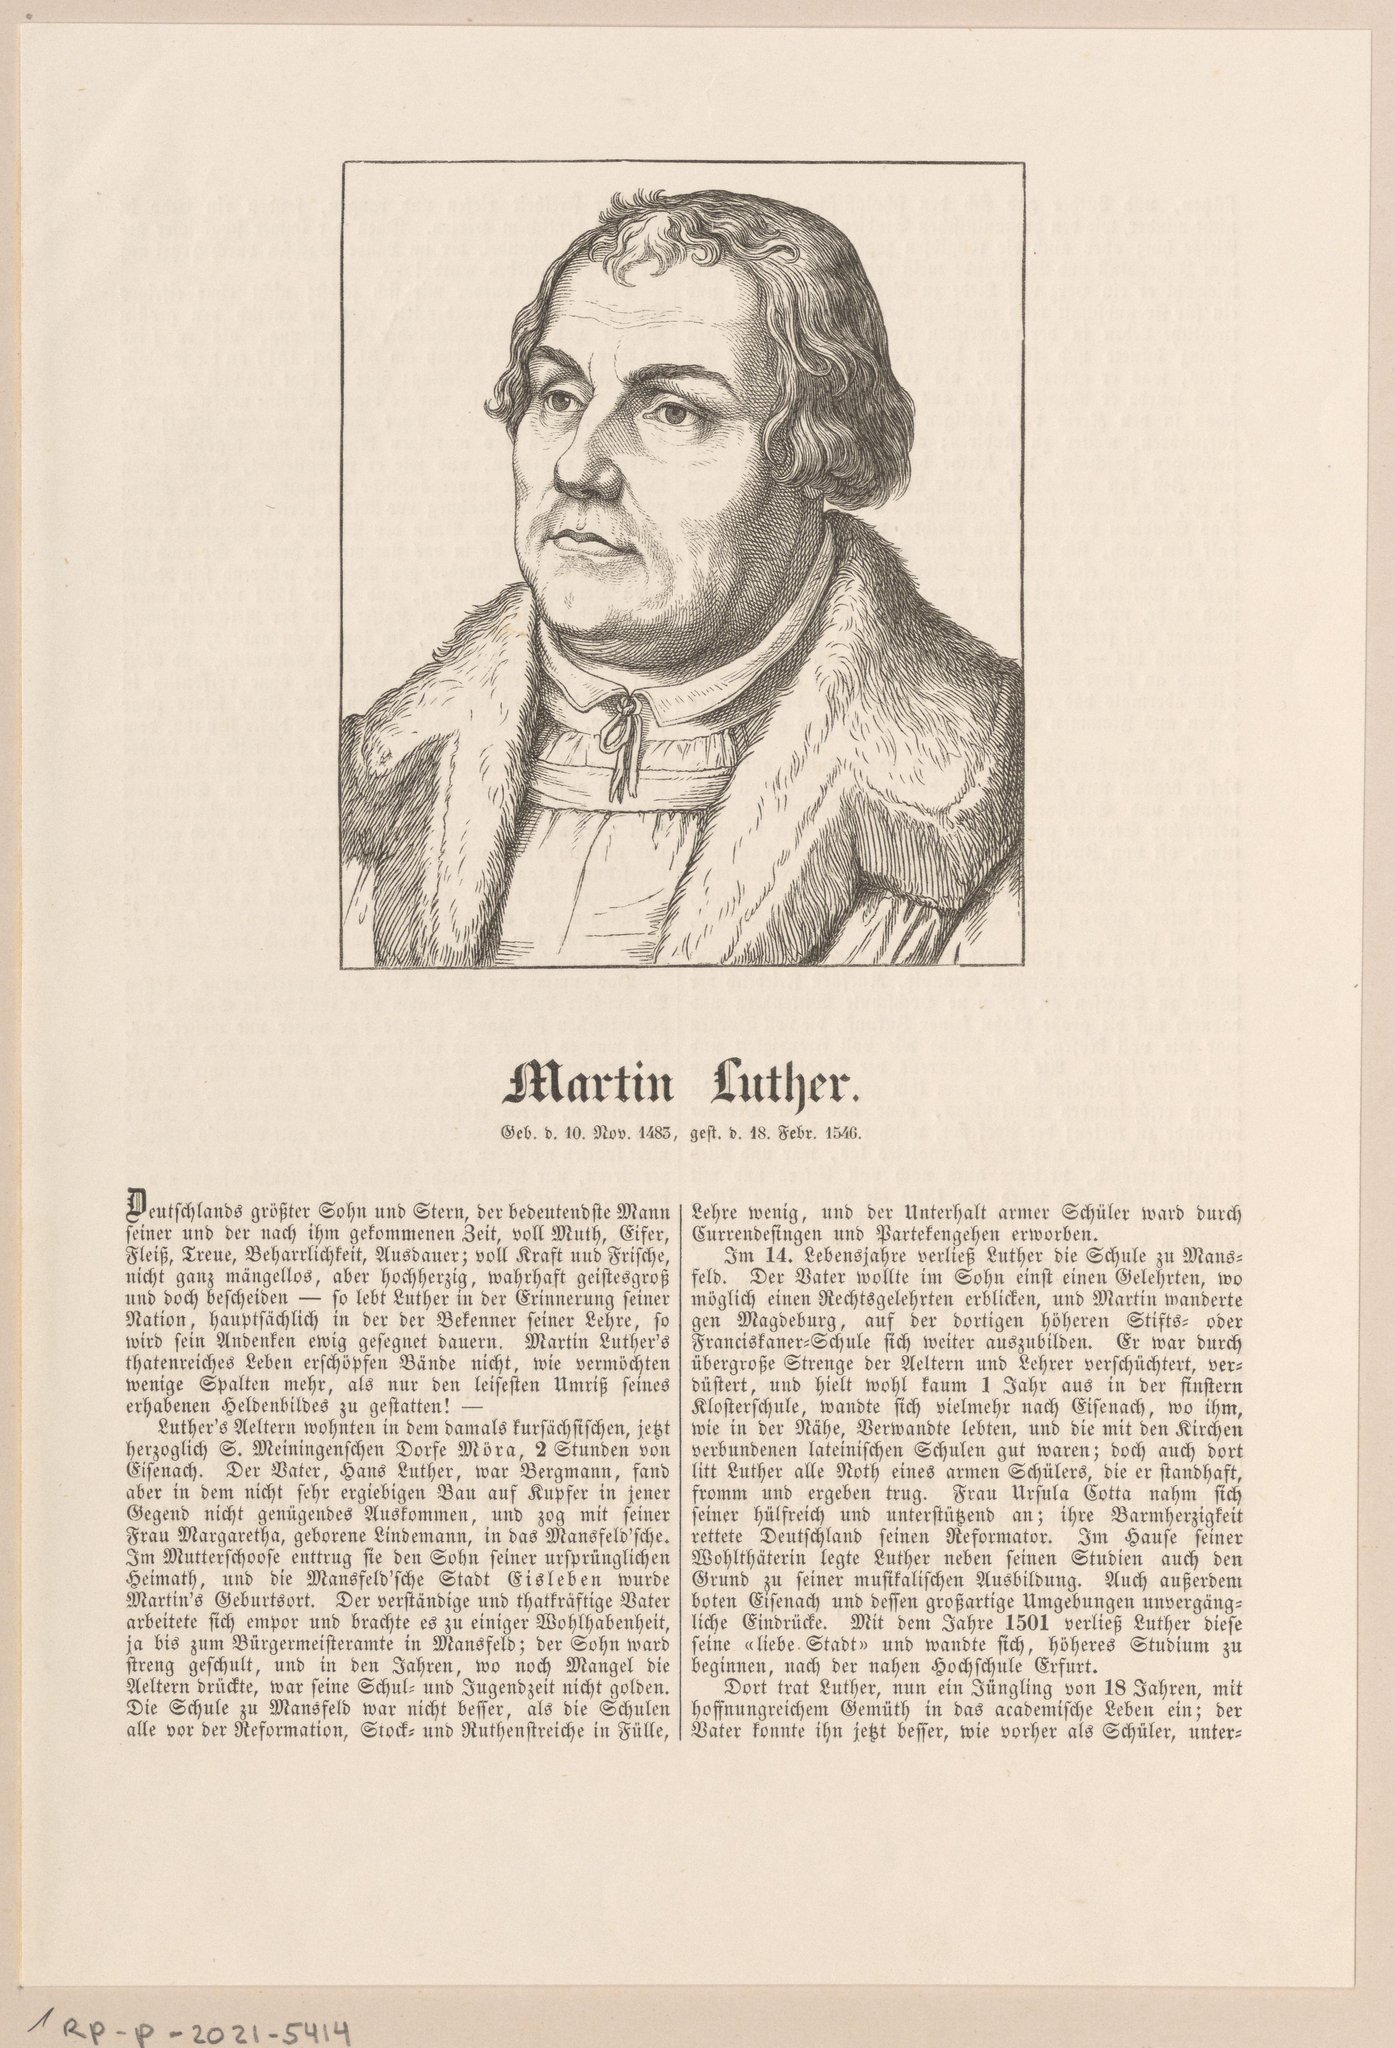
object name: print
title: Portret van Martin Luther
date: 1854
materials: paper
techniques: letterpress printing, engraving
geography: leipzig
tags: priest, martin luther, theologian, historical persons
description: Bladzijde uit: Bechstein, Ludwig. Zweihundert deutsche Männer in Bildnissen und Lebensbeschreibungen. Leipzig: Georg Wigand, 1854. Prent ook gebruikt in 'Dreihundert Bildnisse und Lebensabrisse berühmter deutscher Männer', waarbij op de titelpagina vermeld staat dat de prenten zijn gemaakt door Hugo Bürkner.